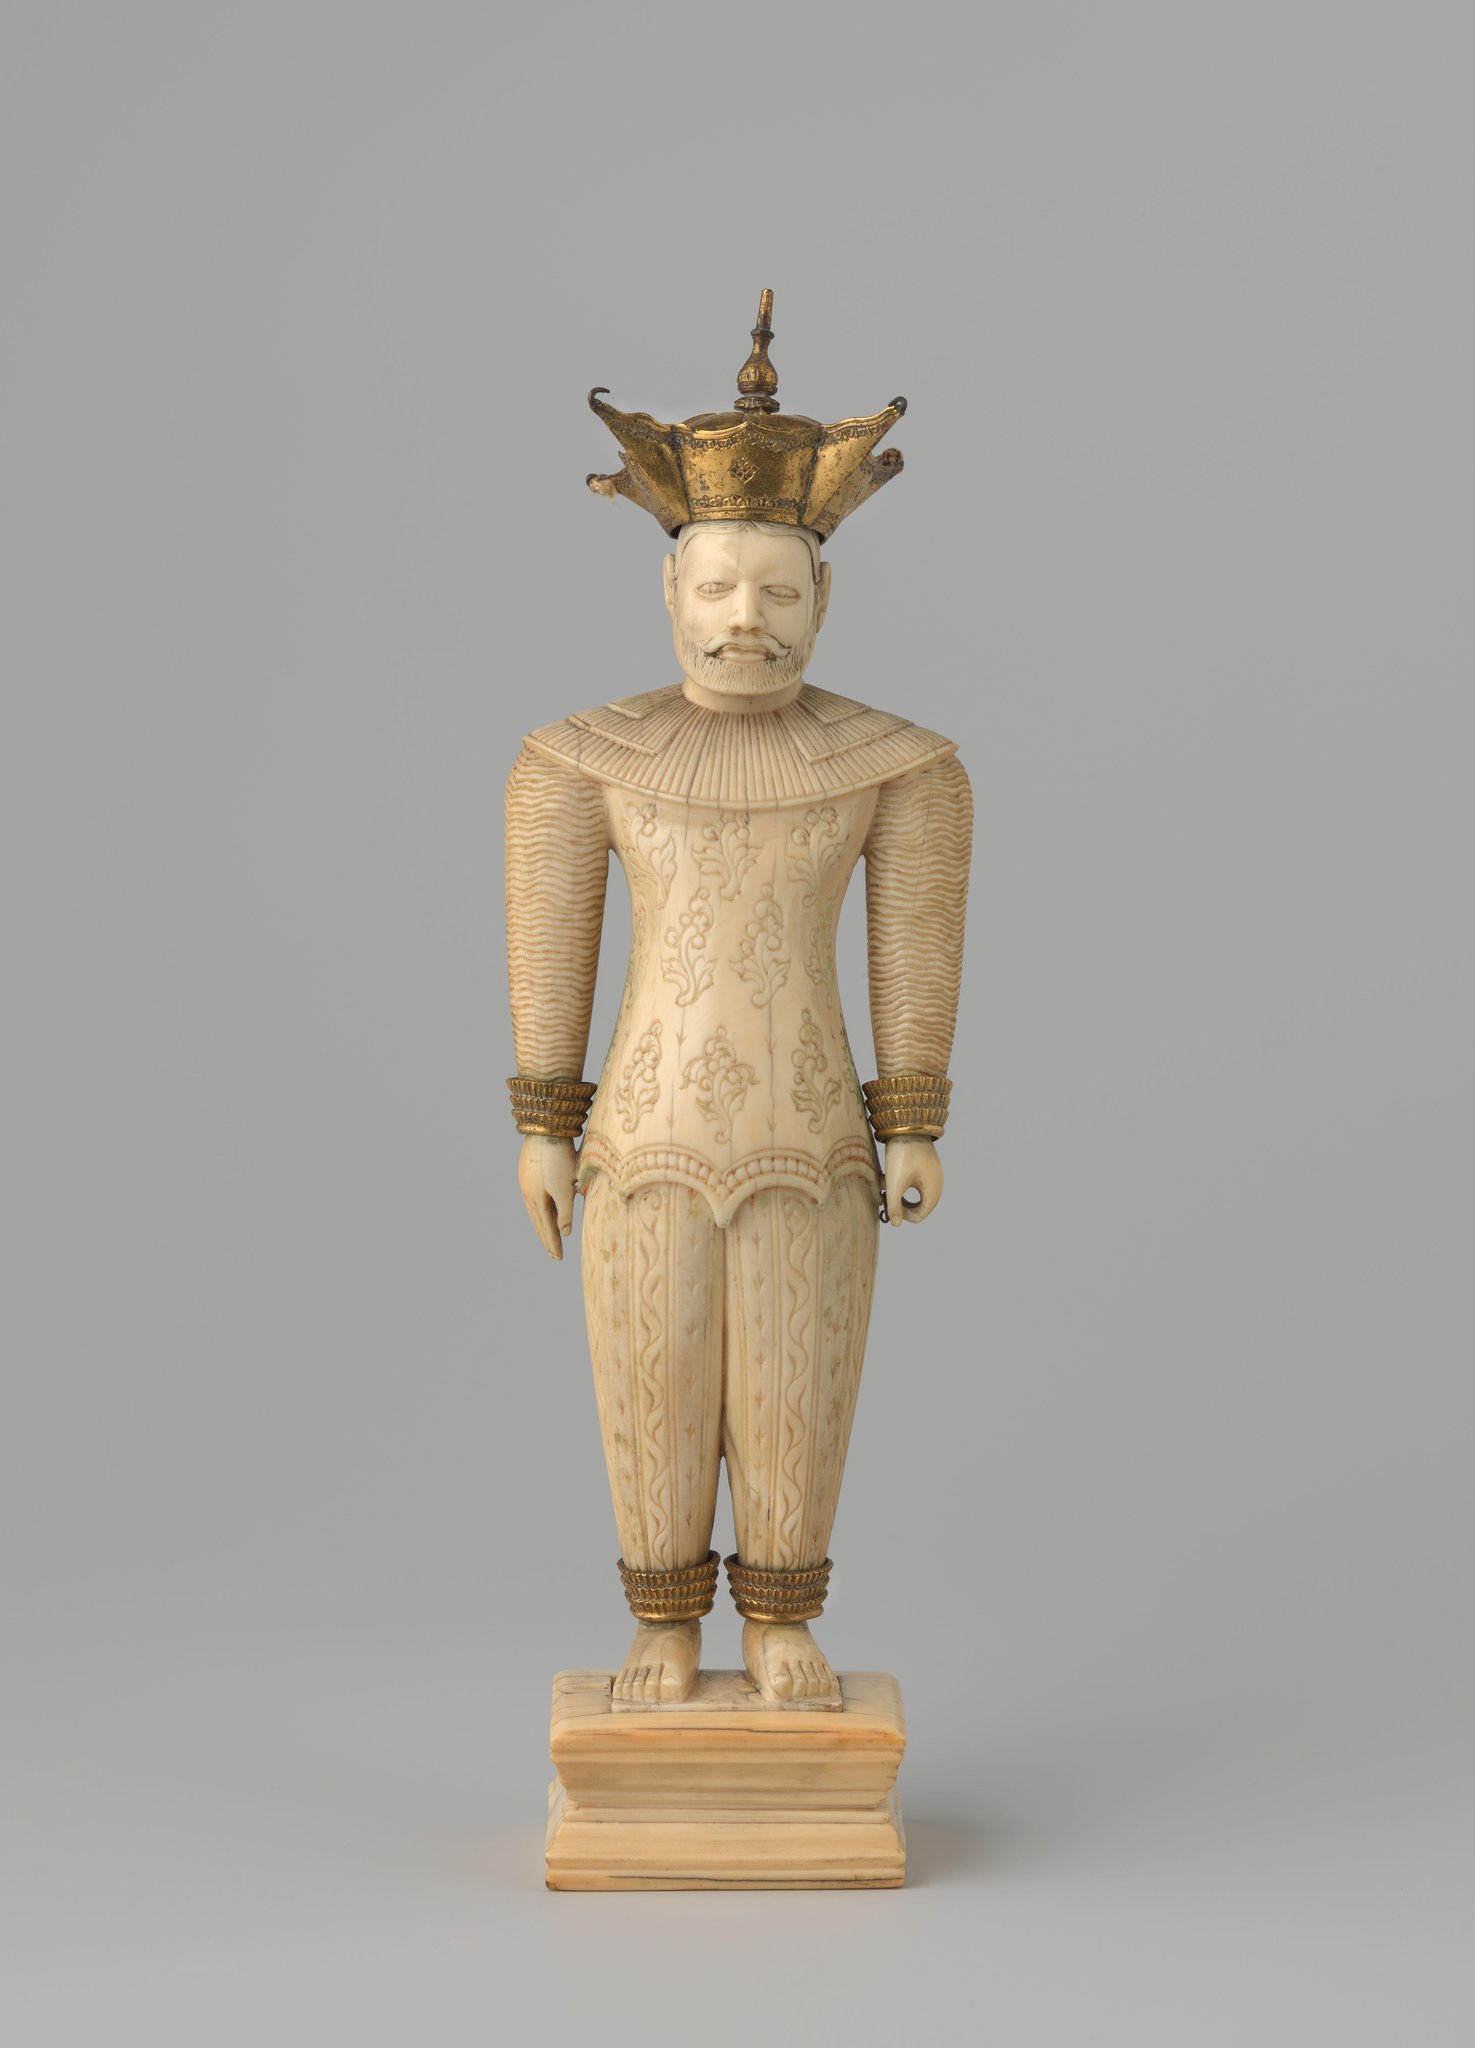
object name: figure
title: King and Queen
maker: Anonymous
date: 1750-1800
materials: ivory, silver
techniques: cutting, gilding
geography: kandy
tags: kandy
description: Ivory figurines of kings from Sri Lanka and South India were crafted from the 16th century onwards as acts of reverence or as mementos of the monarch. These two later examples likely do not represent specific individuals but were created as diplomatic gifts or souvenirs for the European market.